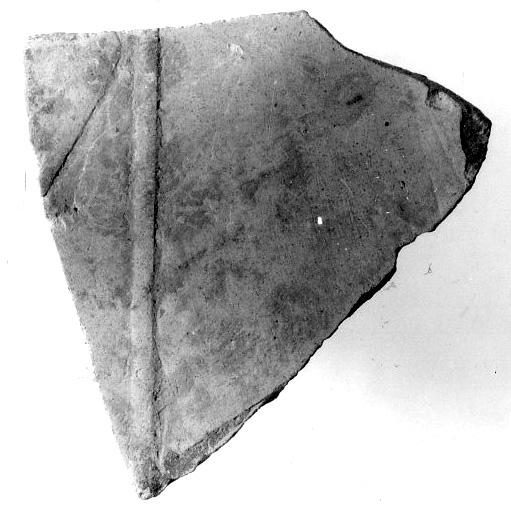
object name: relief fragment, tomb of meketre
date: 1981-1975 BCE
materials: limestone, paint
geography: egypt